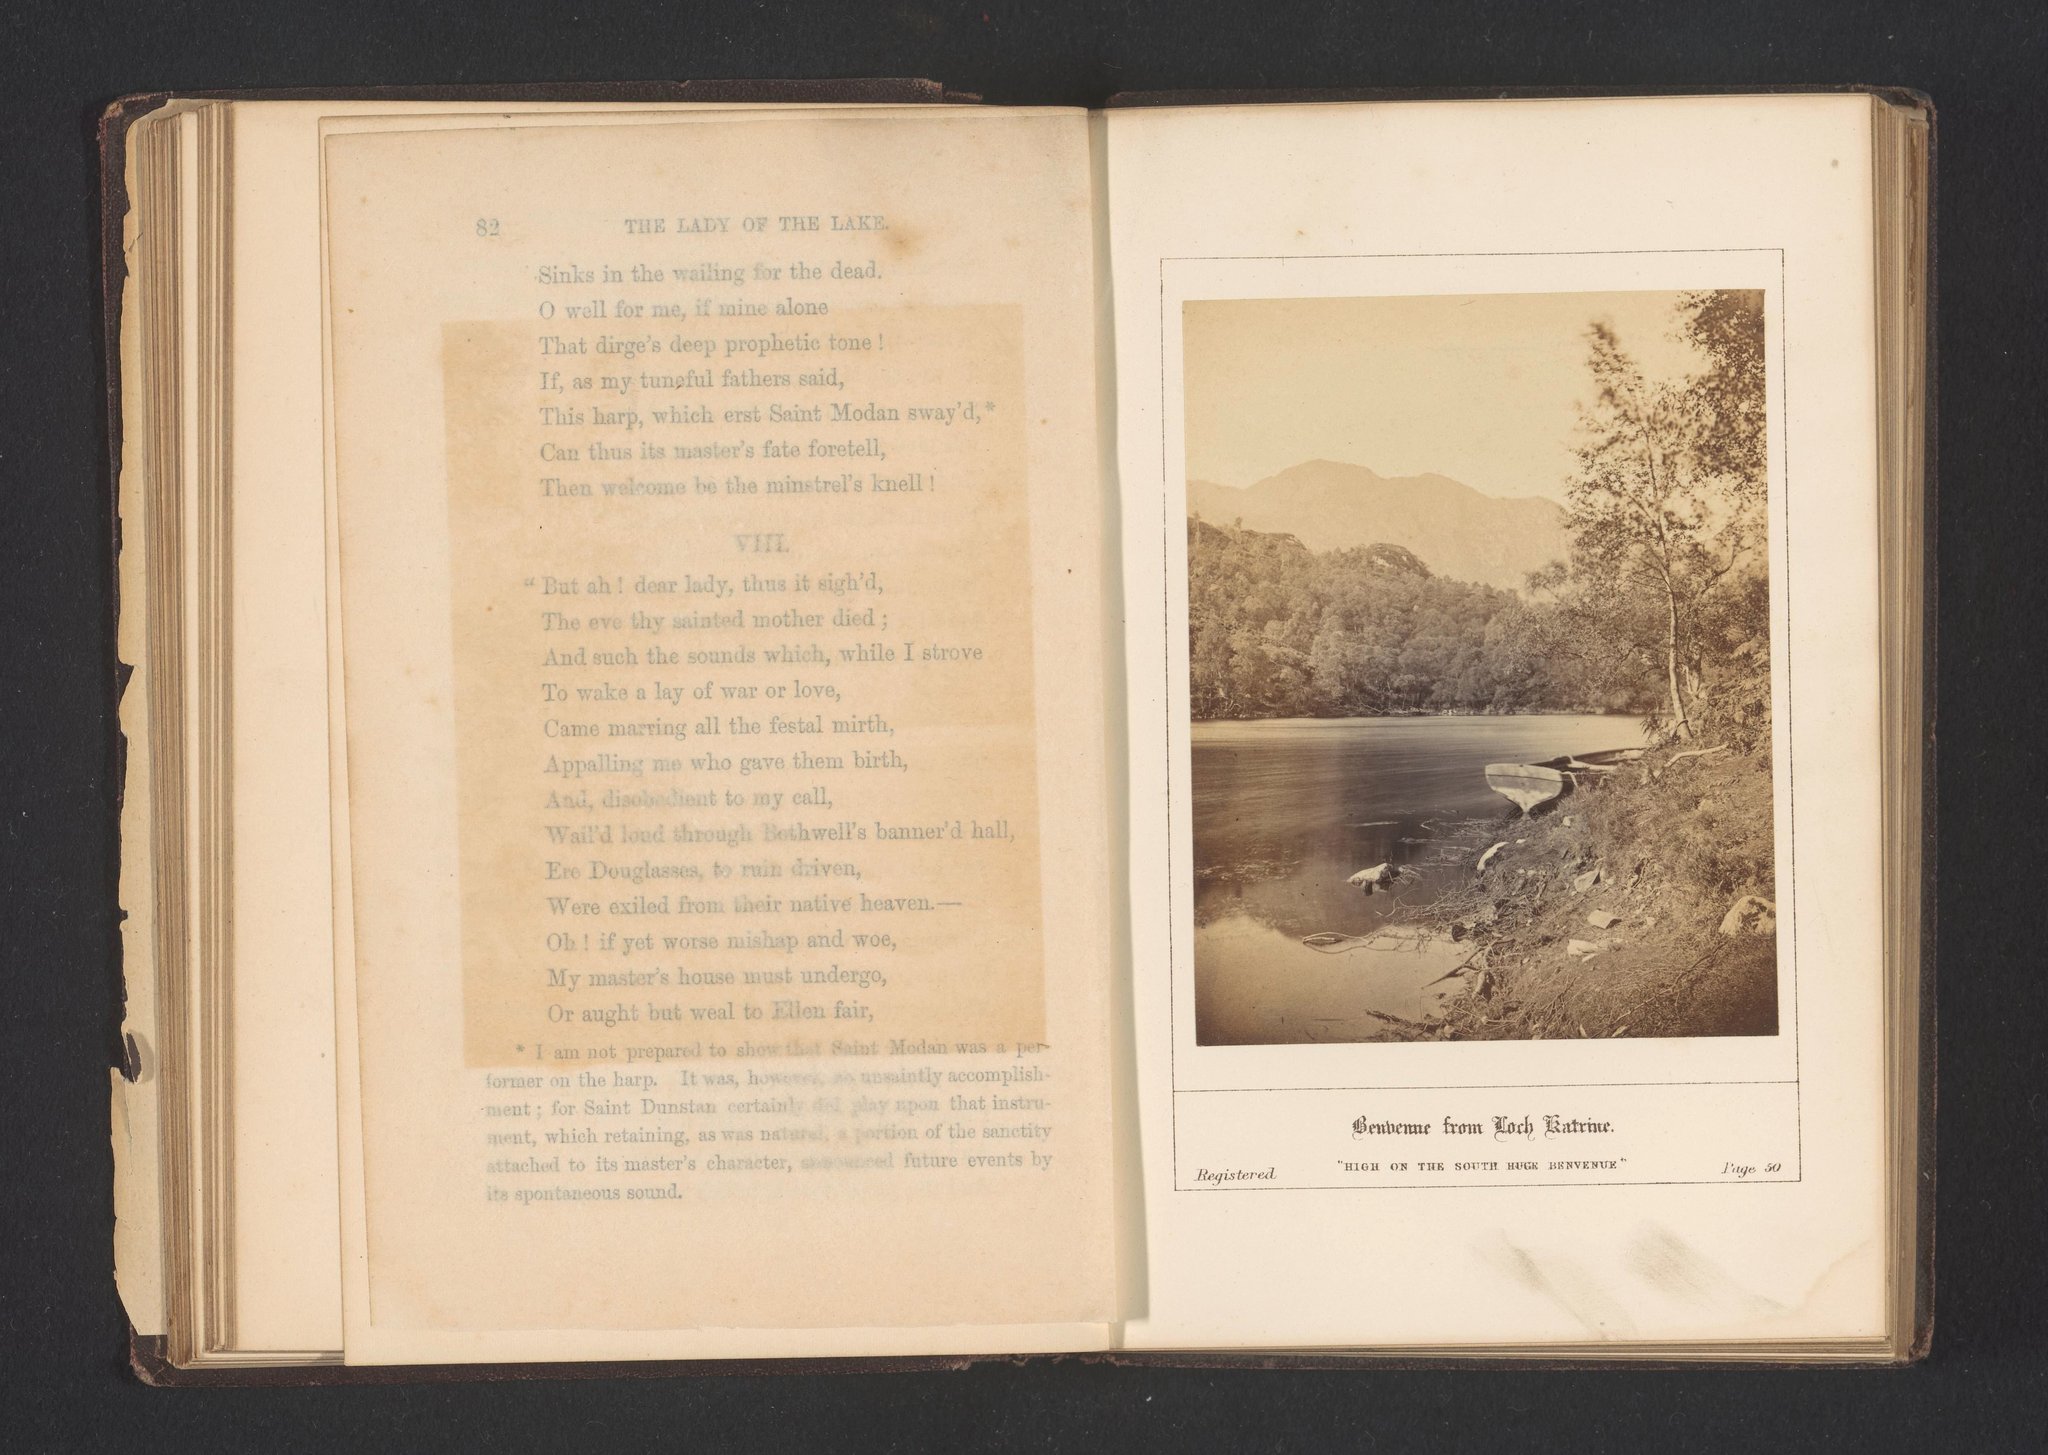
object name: page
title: Gezicht op Ben Venue en Loch Katrine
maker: george washington wilson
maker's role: publisher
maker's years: 1823-1893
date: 1855-1865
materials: photographic support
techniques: albumen print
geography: loch katrine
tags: lake, forest, wood, mountains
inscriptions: inscription: ‘“High on the South huge Benvenue”’, number: ‘Page 50.’